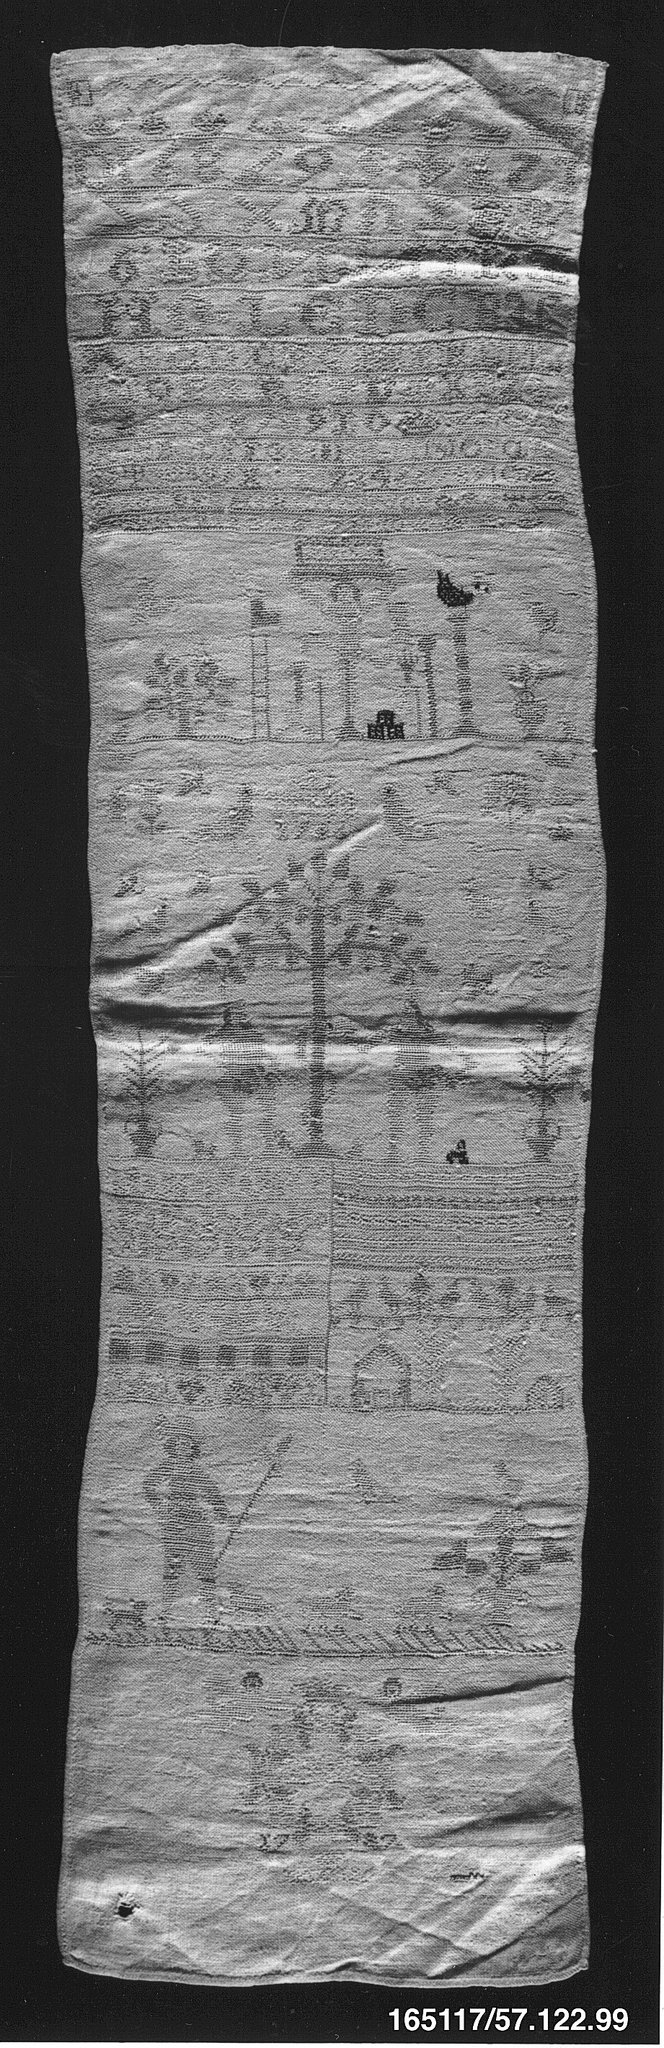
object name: sampler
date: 1787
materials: linen, silk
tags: trees